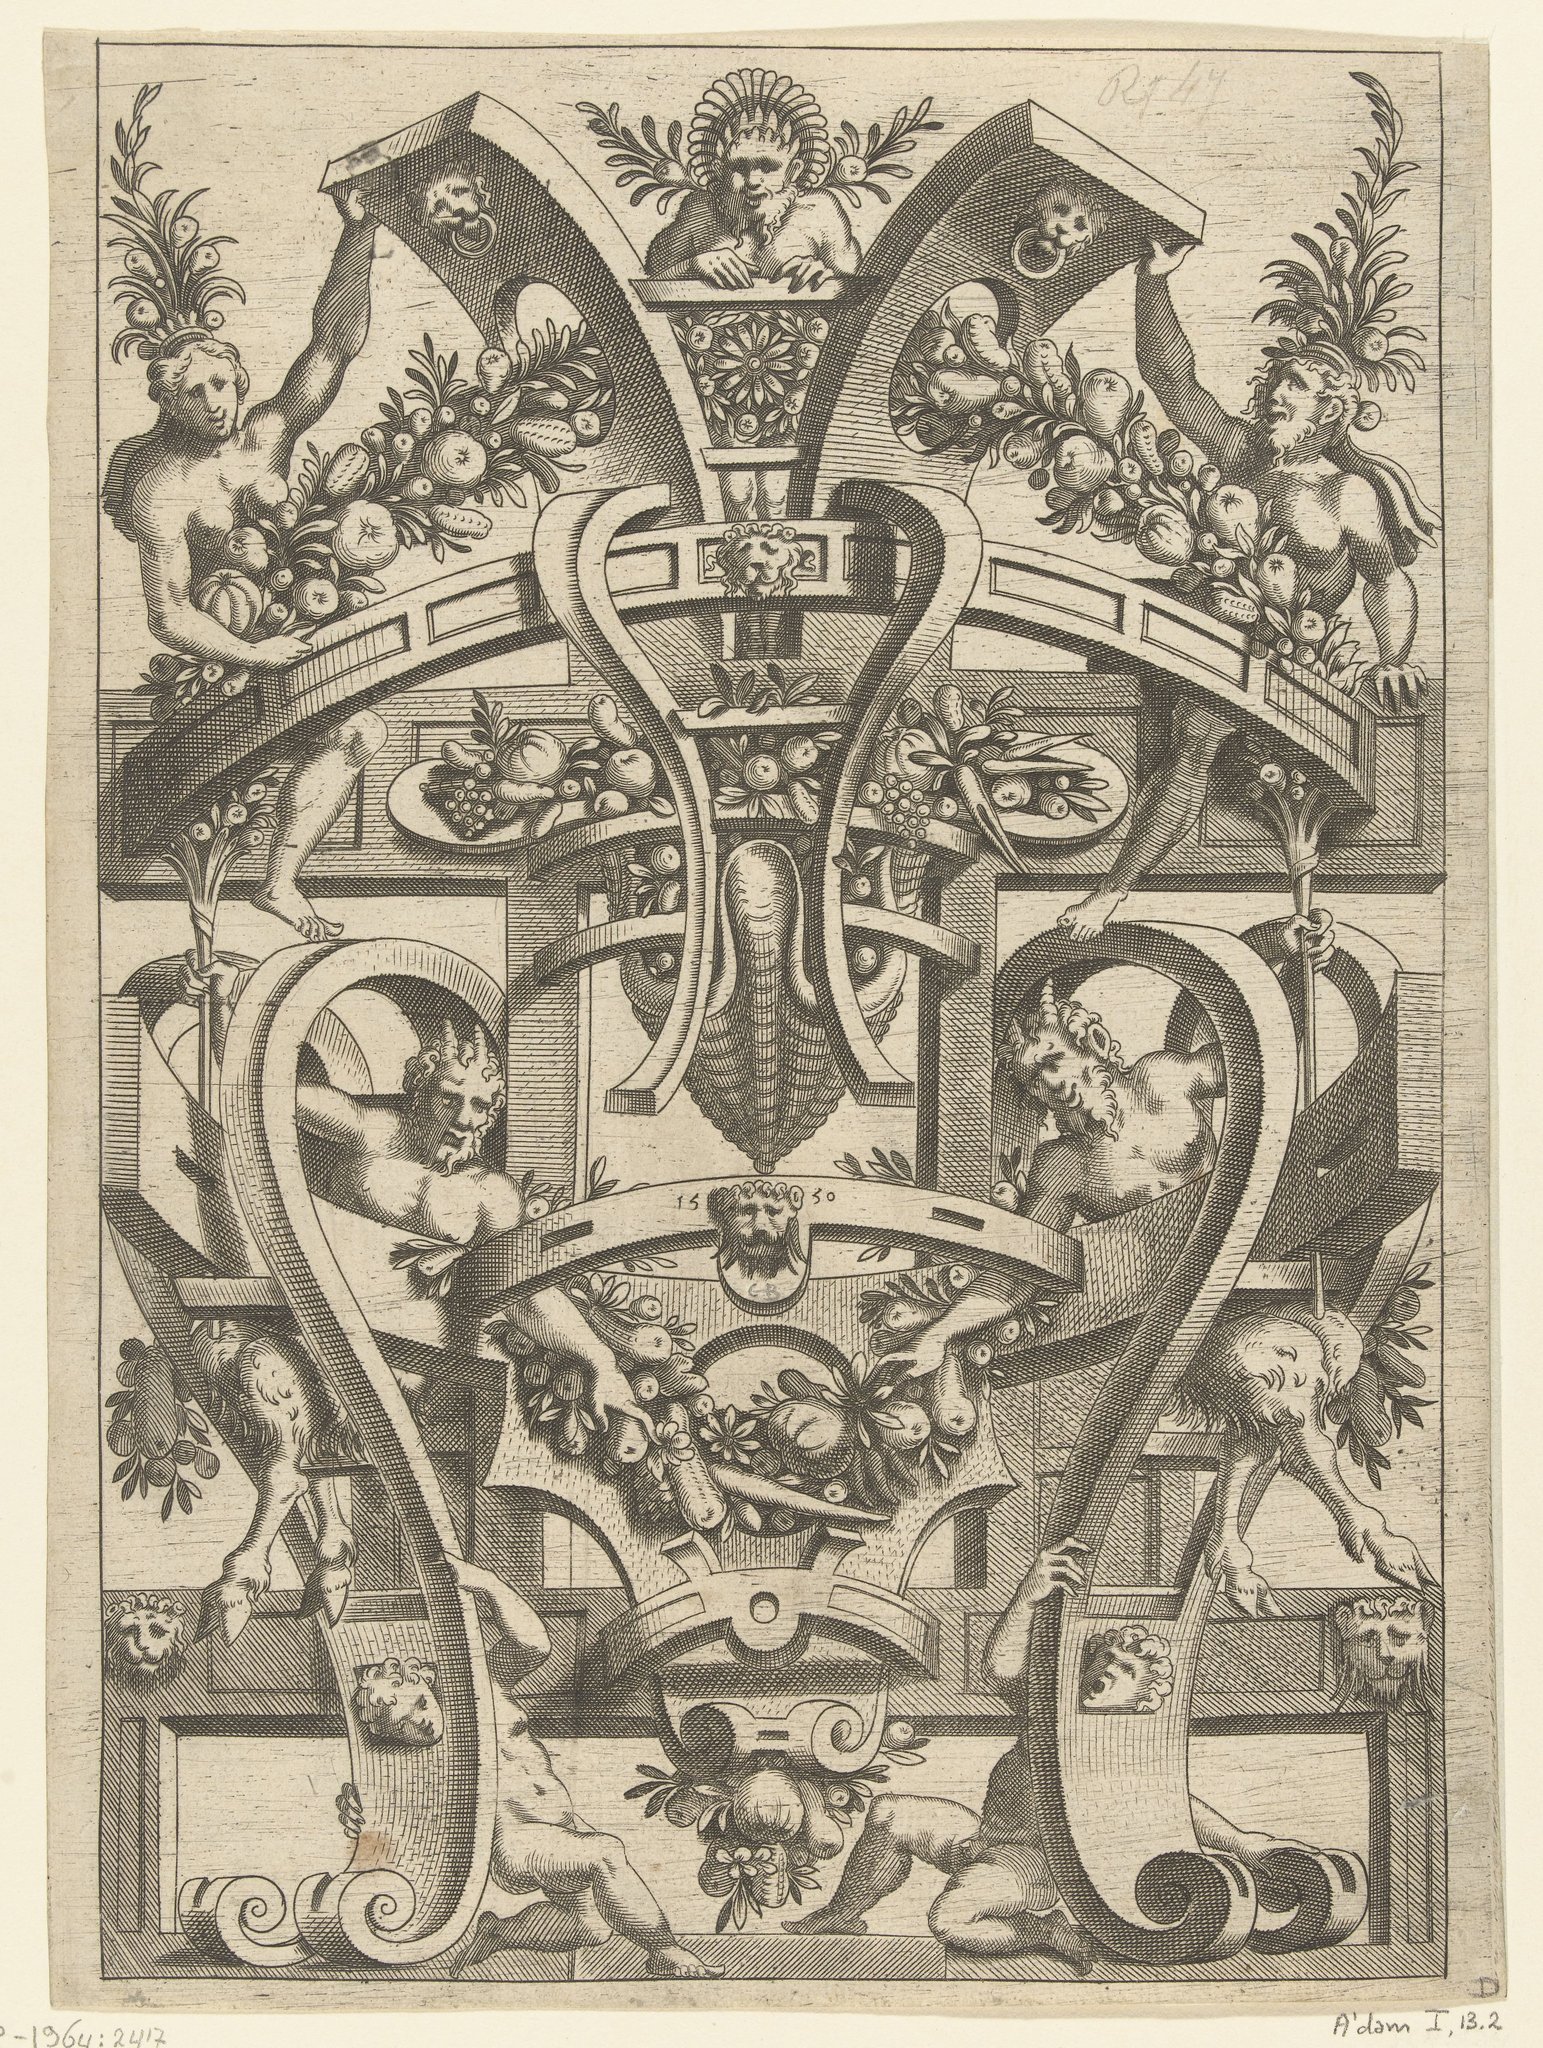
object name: print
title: Groteske vlakdecoraties met rolwerk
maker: Anonymous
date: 1550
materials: paper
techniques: engraving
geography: netherlands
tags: ornament ~ grotesque, scrollwork, strapwork ~ ornament, ornament ~ festoon, garland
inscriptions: date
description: Aan het linker uiteinde van de bovenste guirlande zit een vrouw, aan het rechter uiteinde een man. Zij houden zich beiden met één hand aan het rolwerk vast. Blad uit serie van 6 bladen met groteske vlakdecoraties met rolwerk, kandelabers, saters, vruchtenguirlandes, vogels en fantasiewezens.